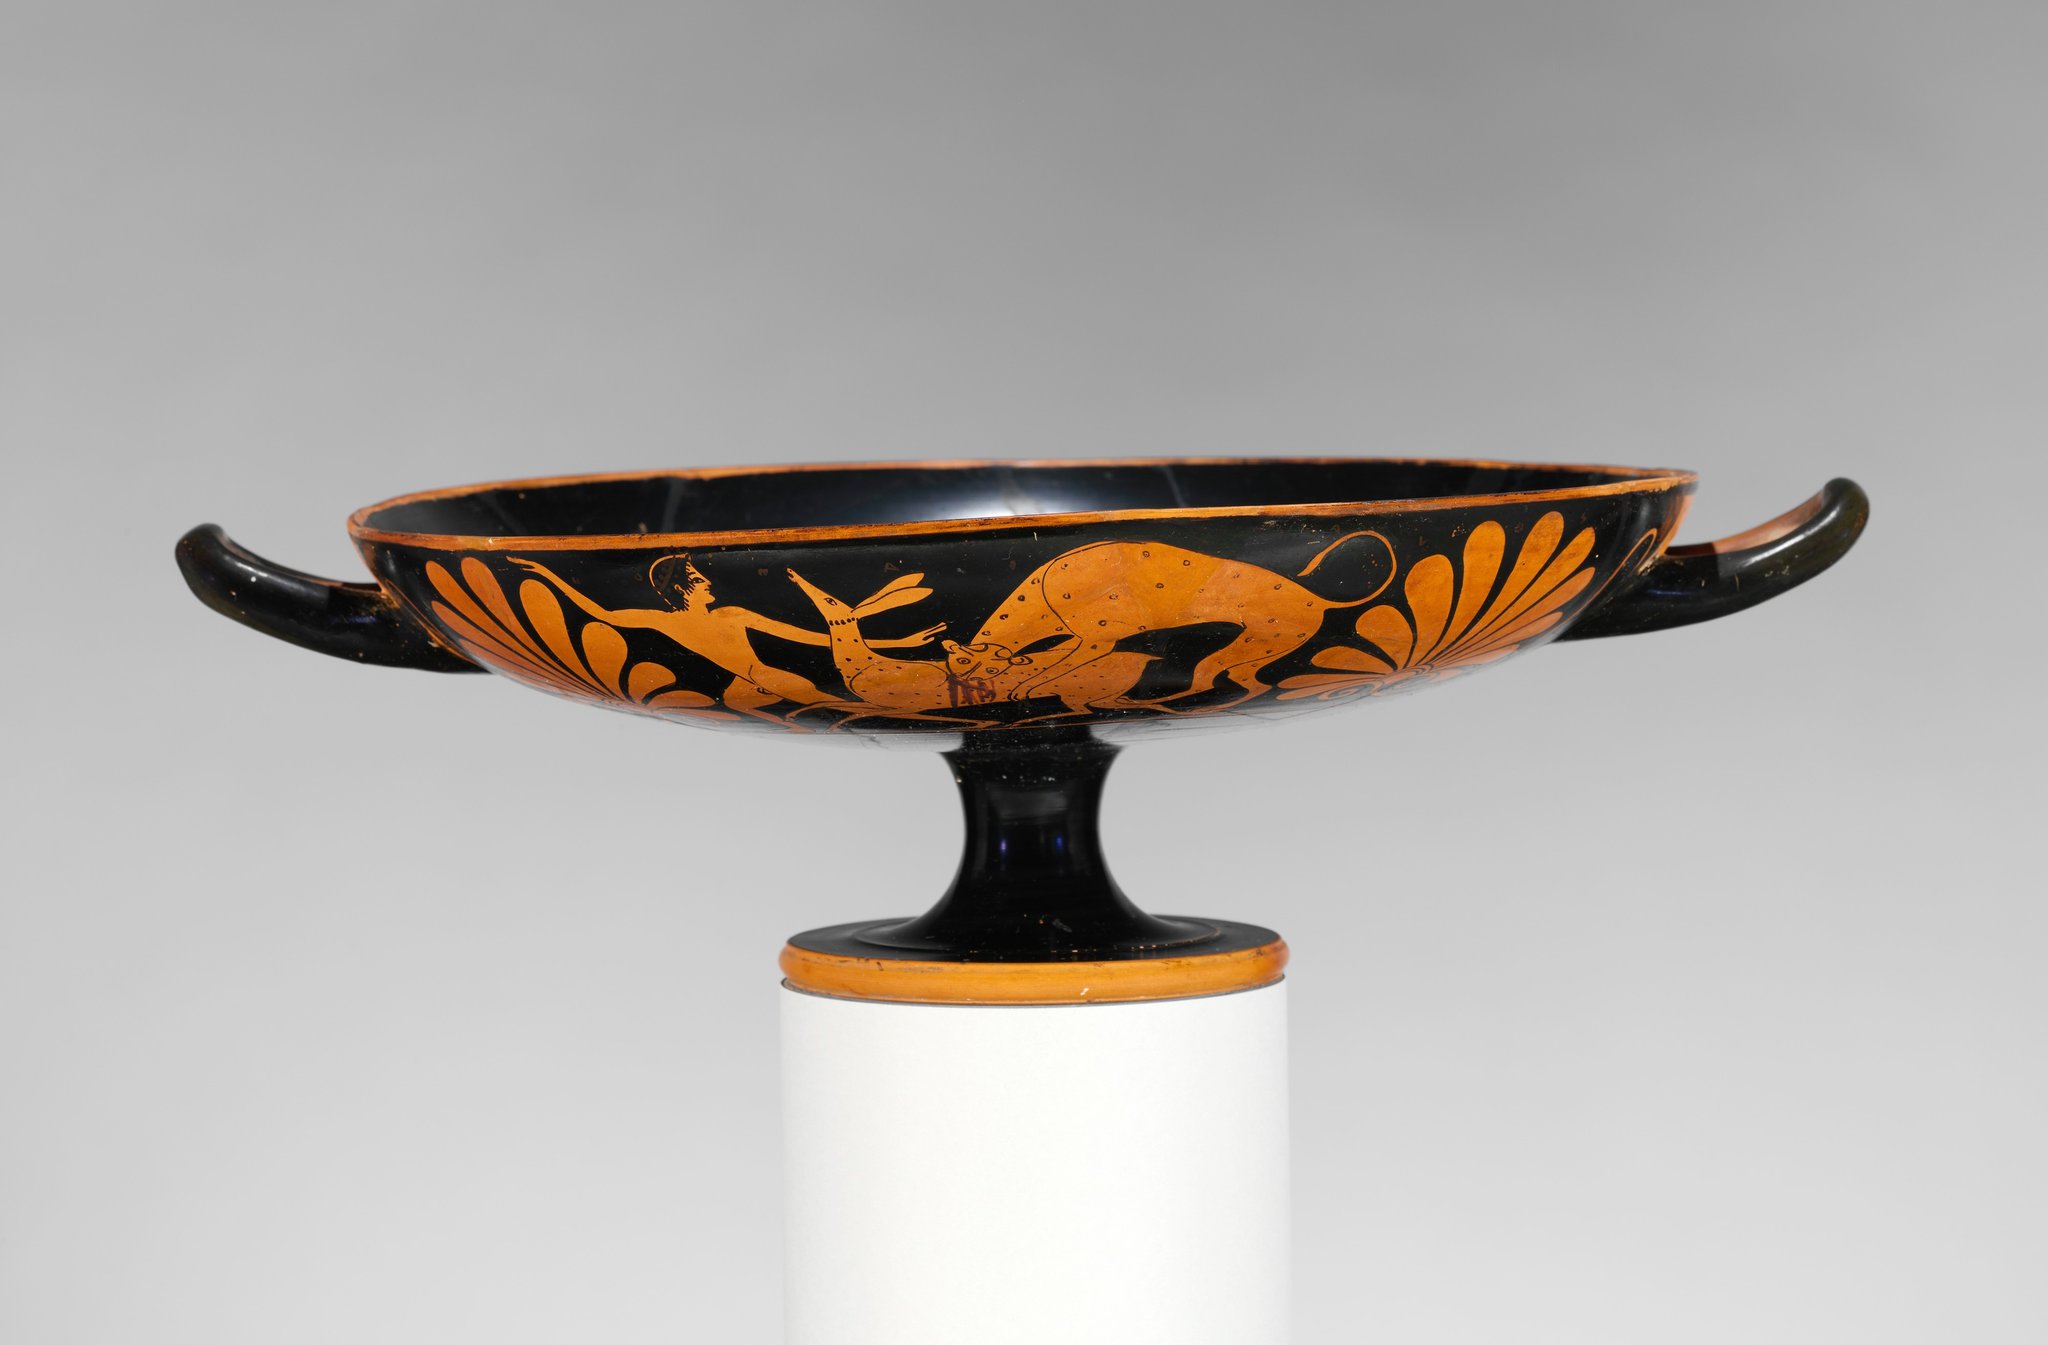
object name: kylix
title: Terracotta kylix (drinking cup)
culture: greek, attic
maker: euergides painter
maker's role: artist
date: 510 BCE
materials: terracotta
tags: animals,men,athletes